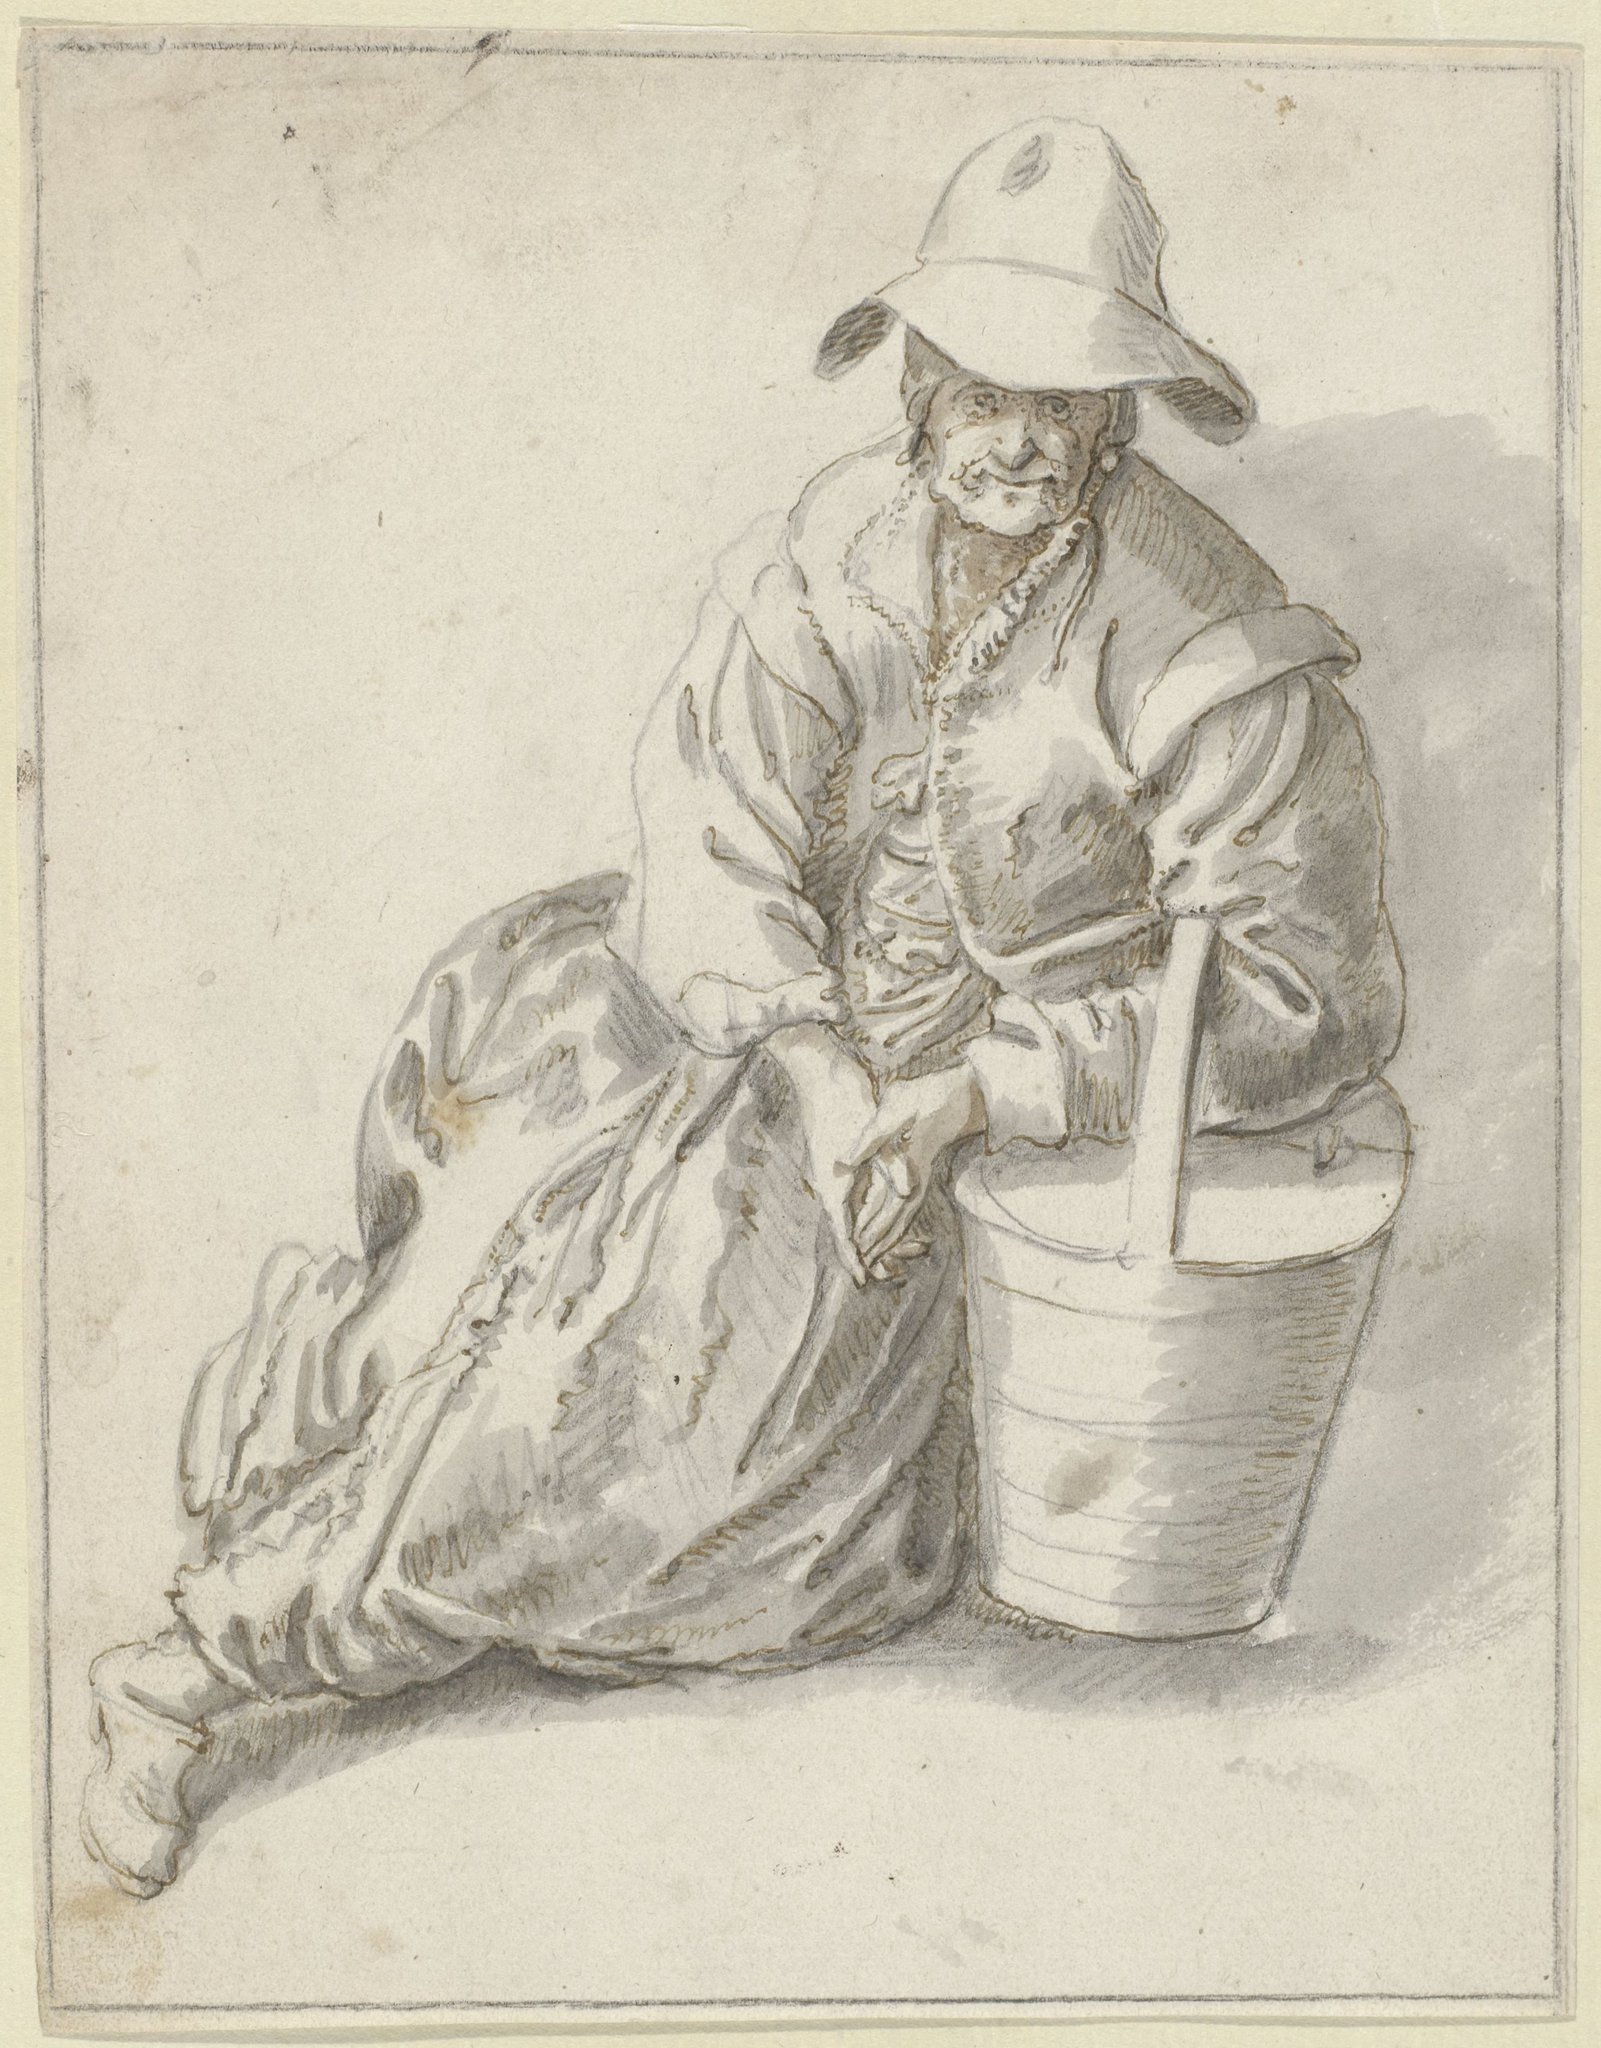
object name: drawing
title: Zittende vrouw, leunend op een mand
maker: Anonymous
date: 1700-1799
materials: paper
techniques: brush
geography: netherlands